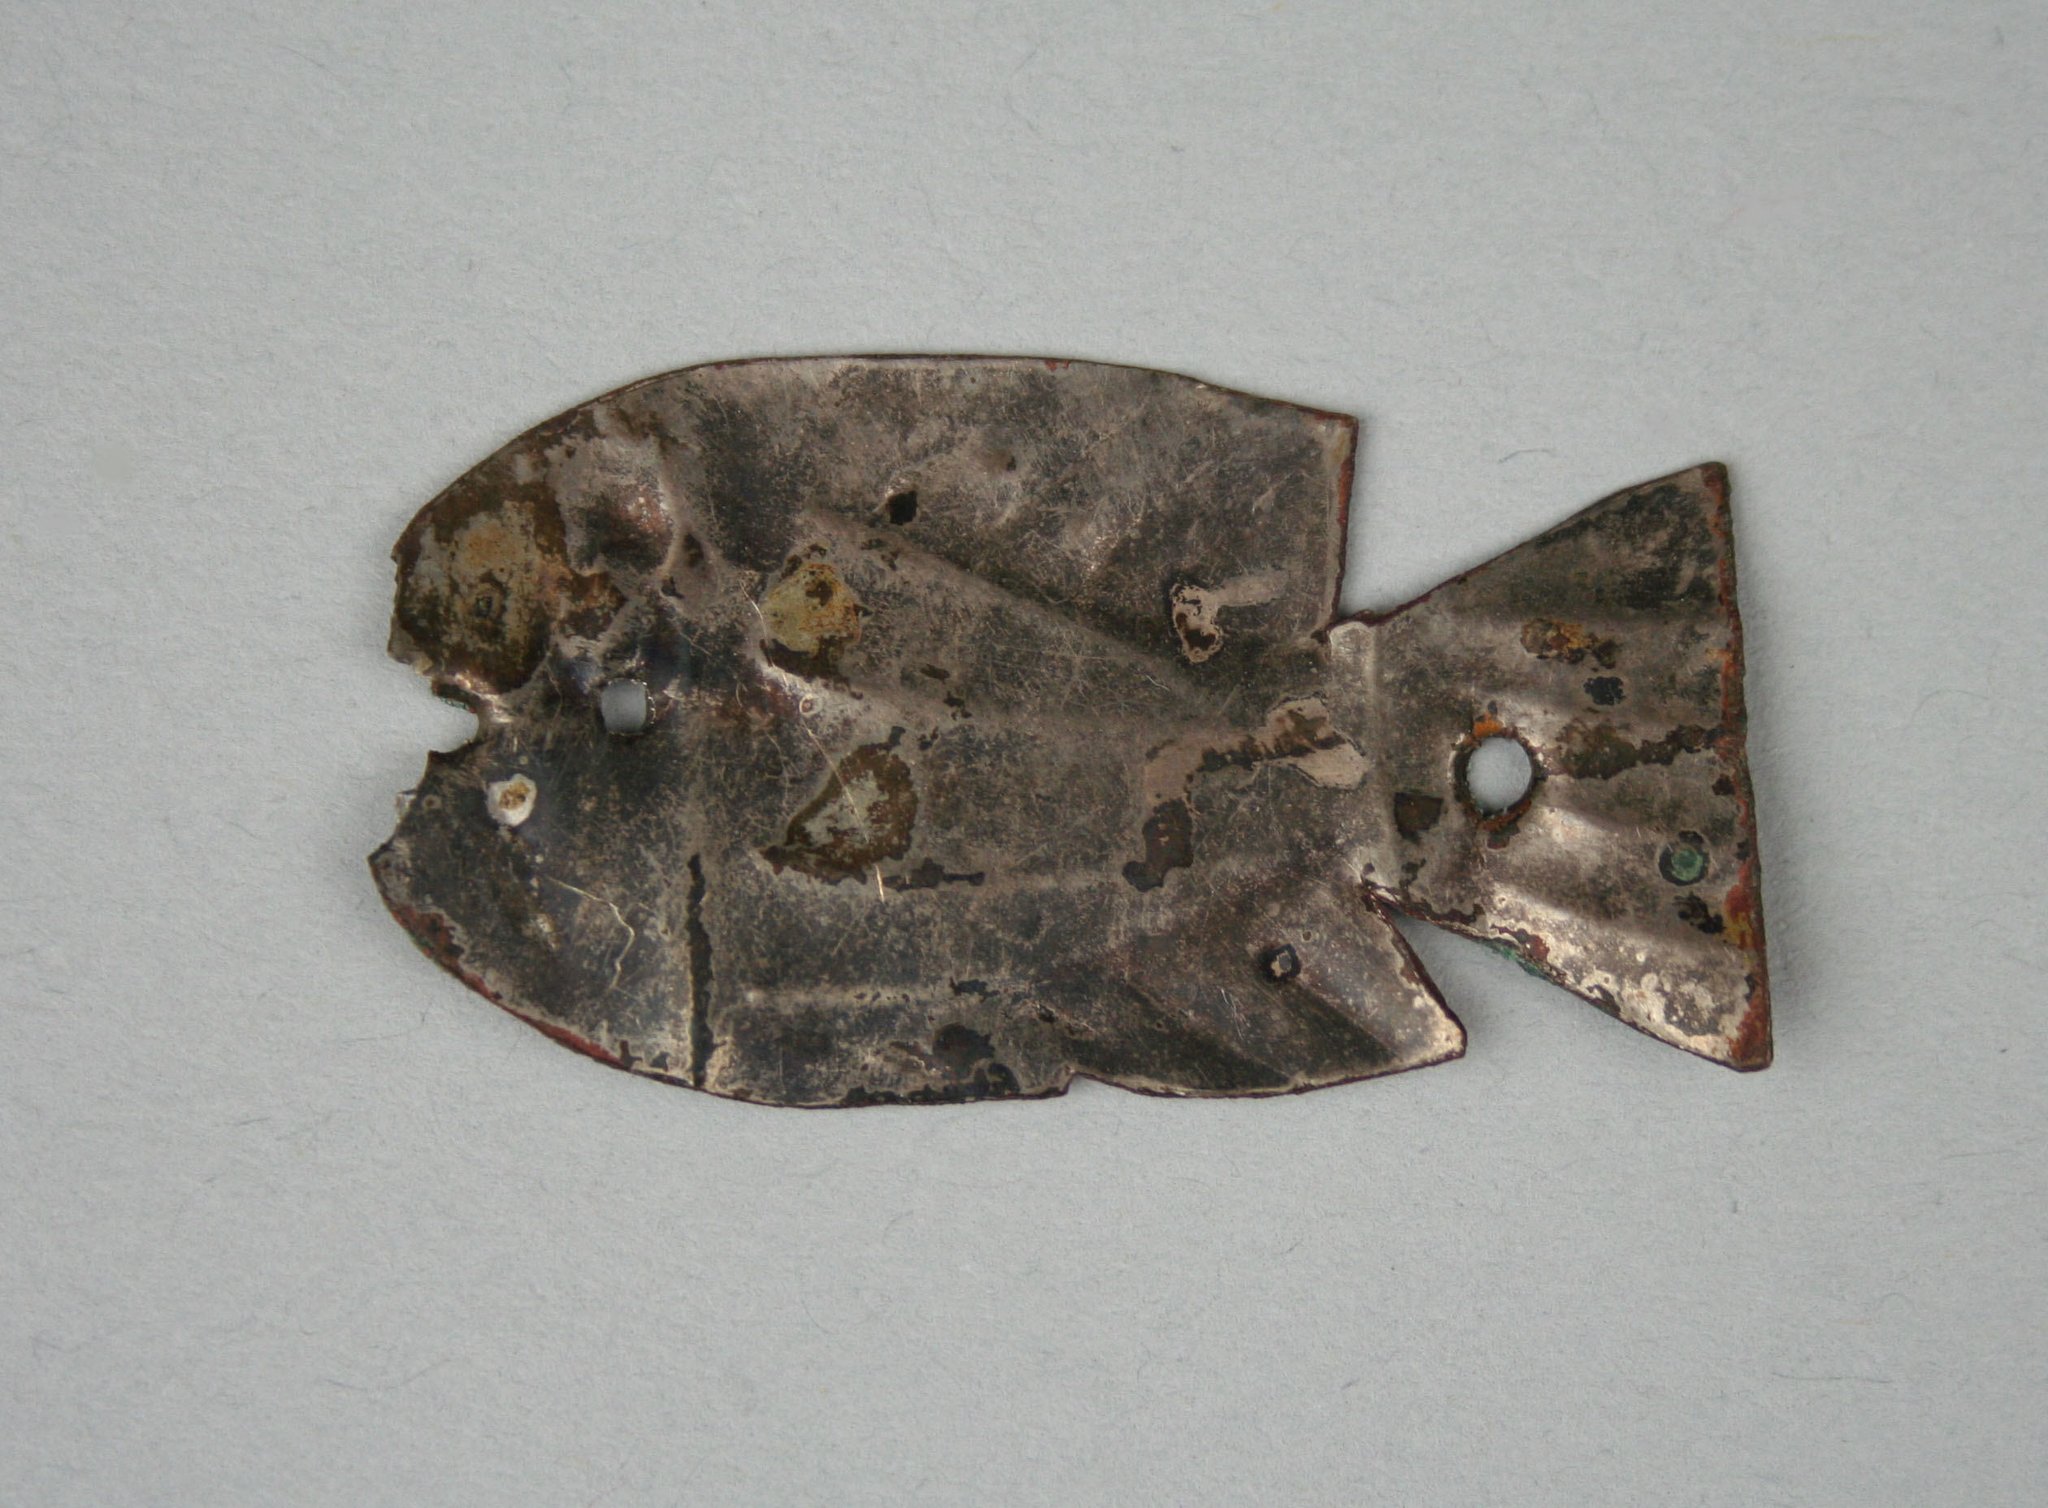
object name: ornament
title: Fish Ornament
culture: peruvian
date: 1001-1200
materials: silver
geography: peru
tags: fish